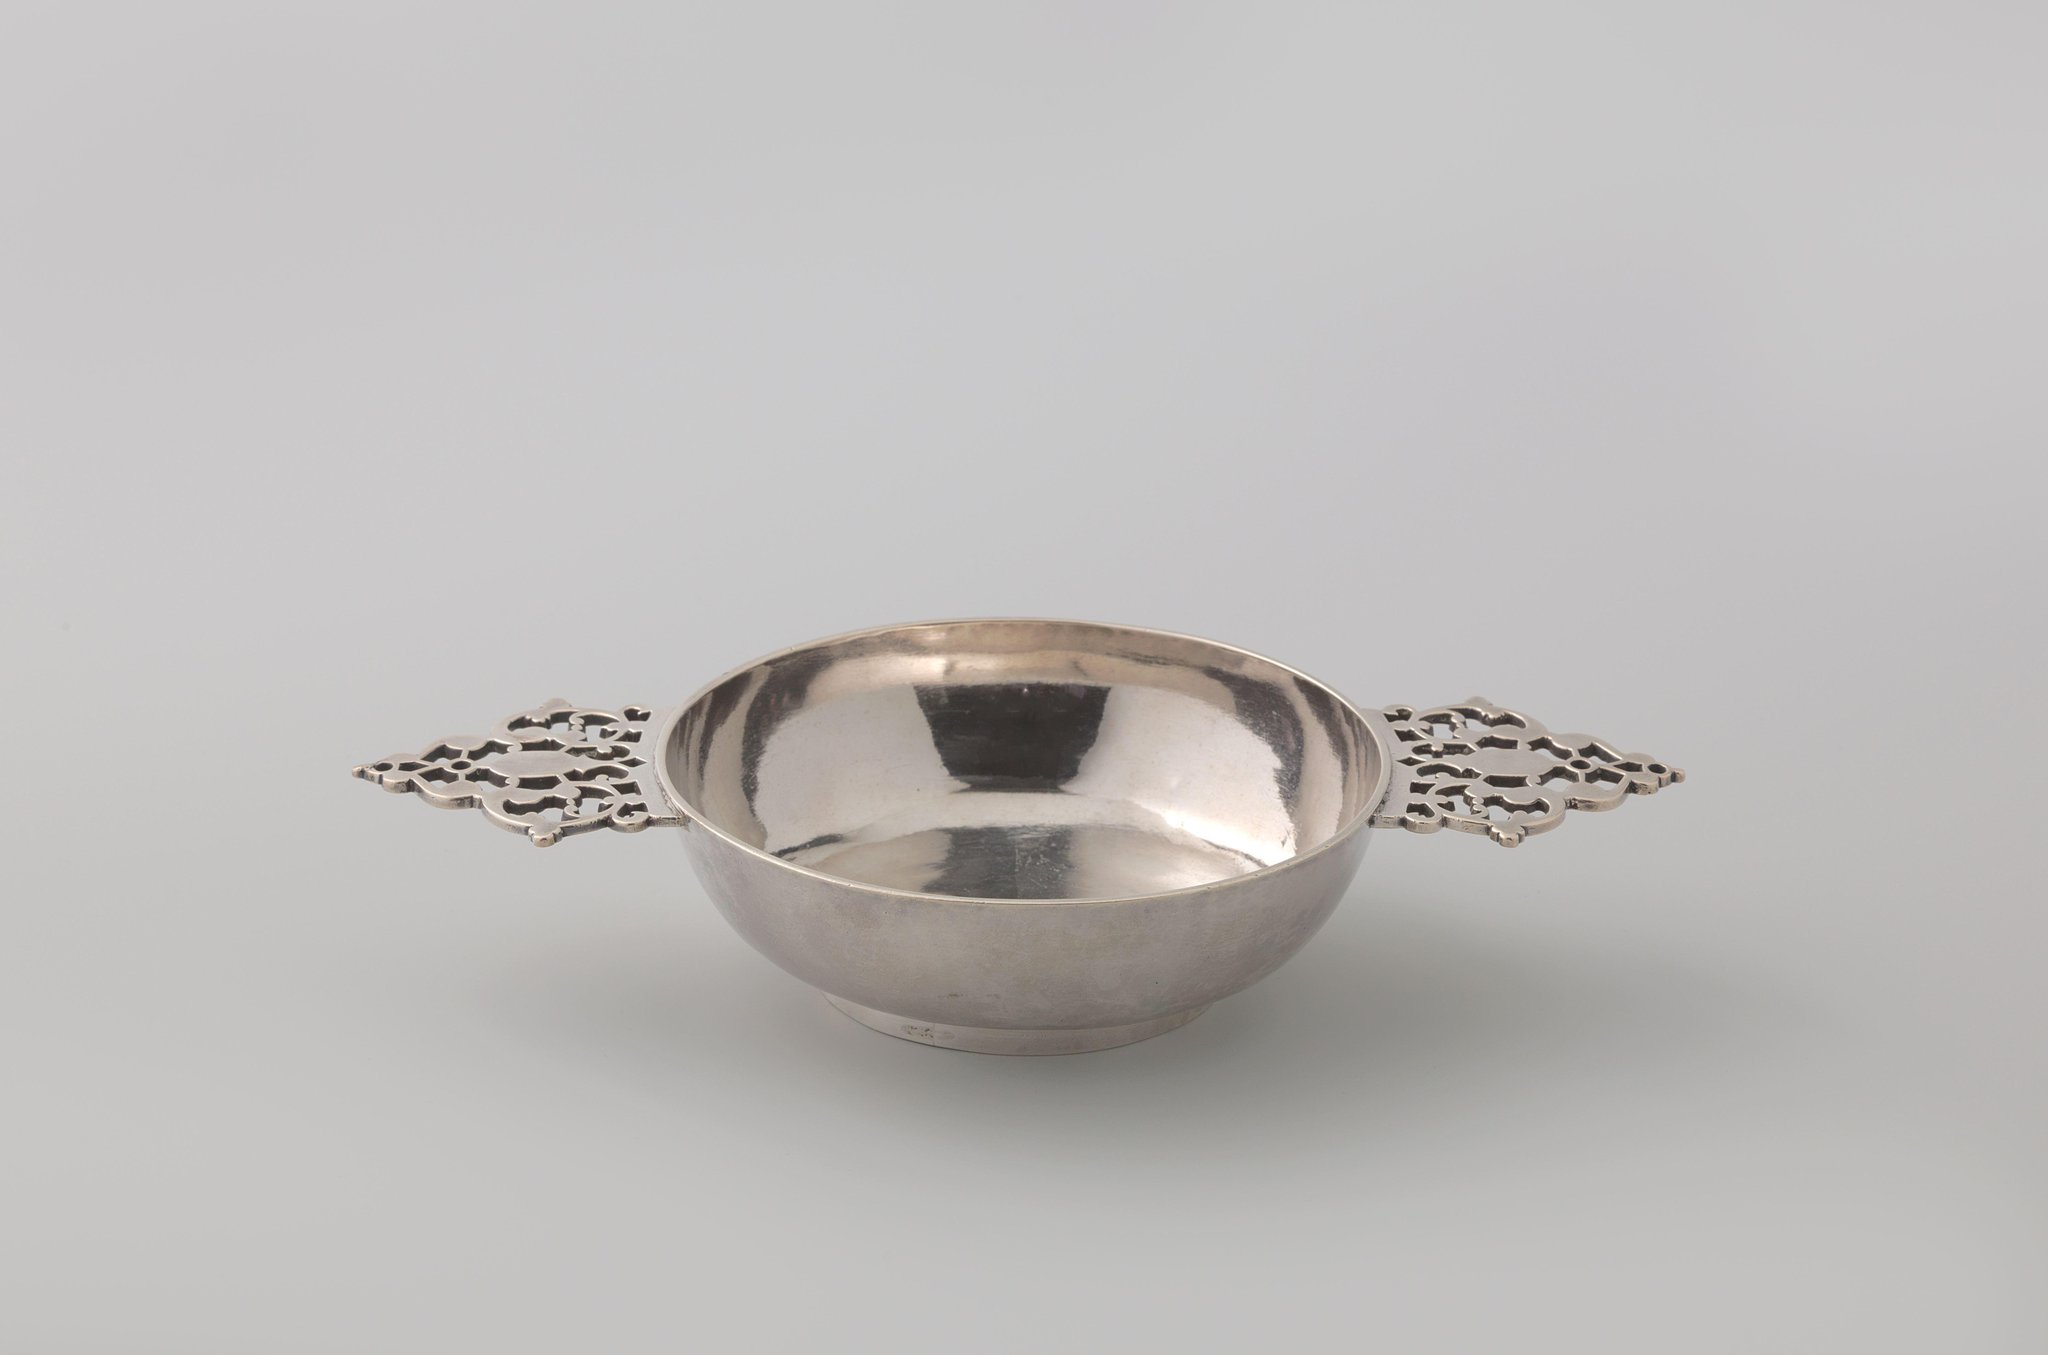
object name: brandy bowl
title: Brandewijnskom van zilver op lage, ronde, onversierde cuppa met twee horizontale uitgezaagde oren. Vals.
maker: jan verdoes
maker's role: jeweler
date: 1746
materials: silver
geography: haarlem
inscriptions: mark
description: Brandewijnkom van zilver. Lage, ronde onversierde cuppa met twee horizontale oren, bestaande uit gezaagd, symmetrisch bandornament.